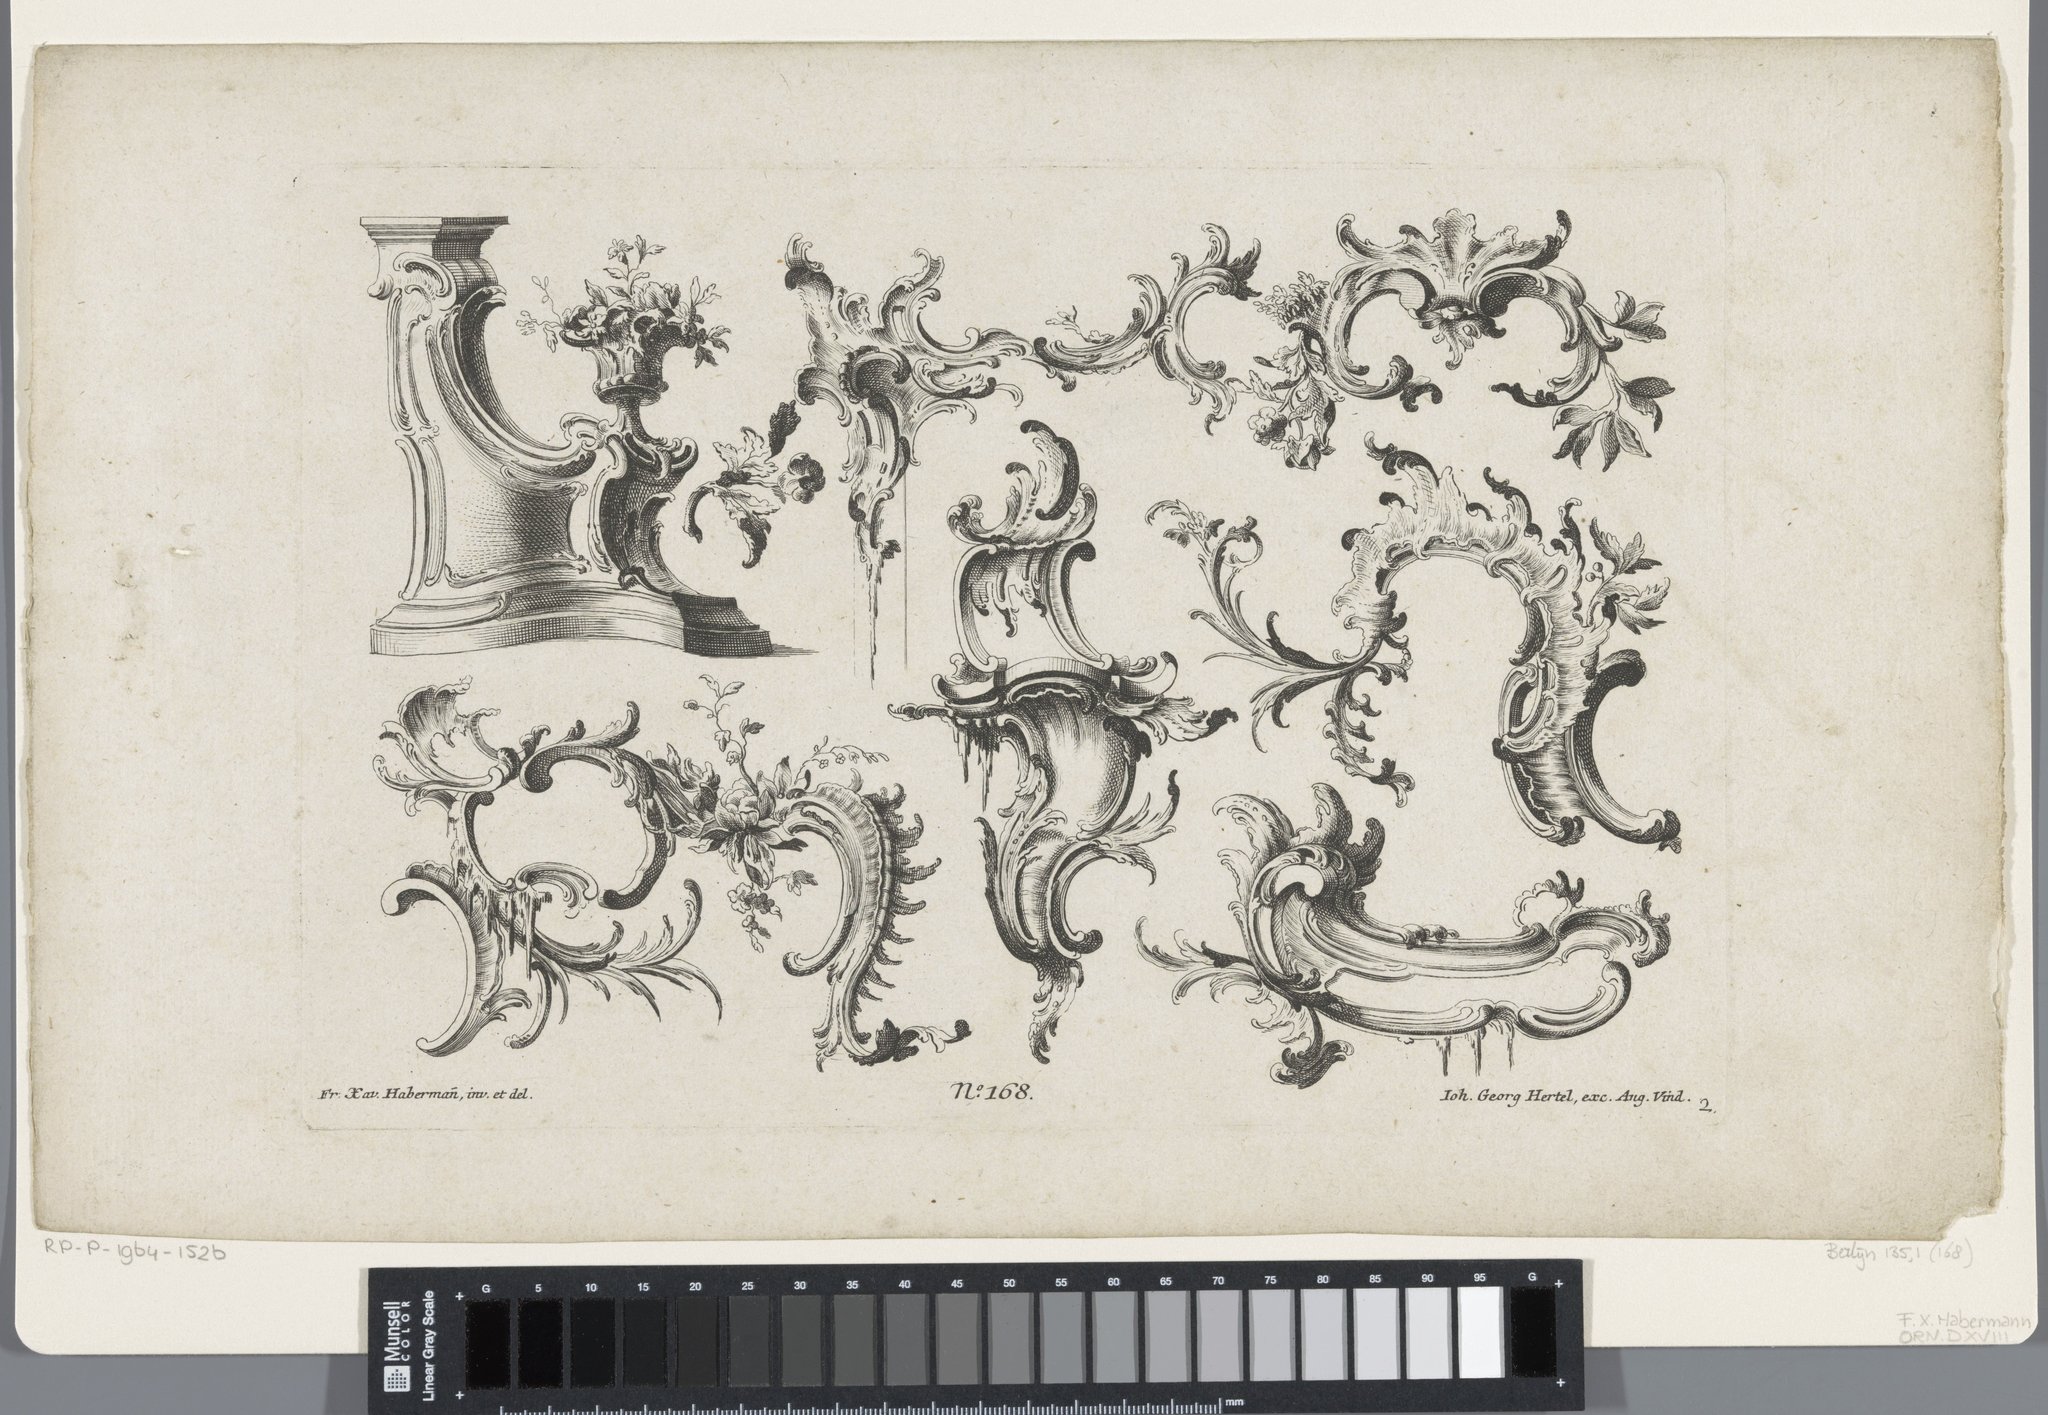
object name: ornament print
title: Rocailles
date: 1750-1775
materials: paper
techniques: etching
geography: augsburg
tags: rocaille ornament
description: Rocaille ornamenten met bloemmotieven en vaas. Uitgeversnummer 168.